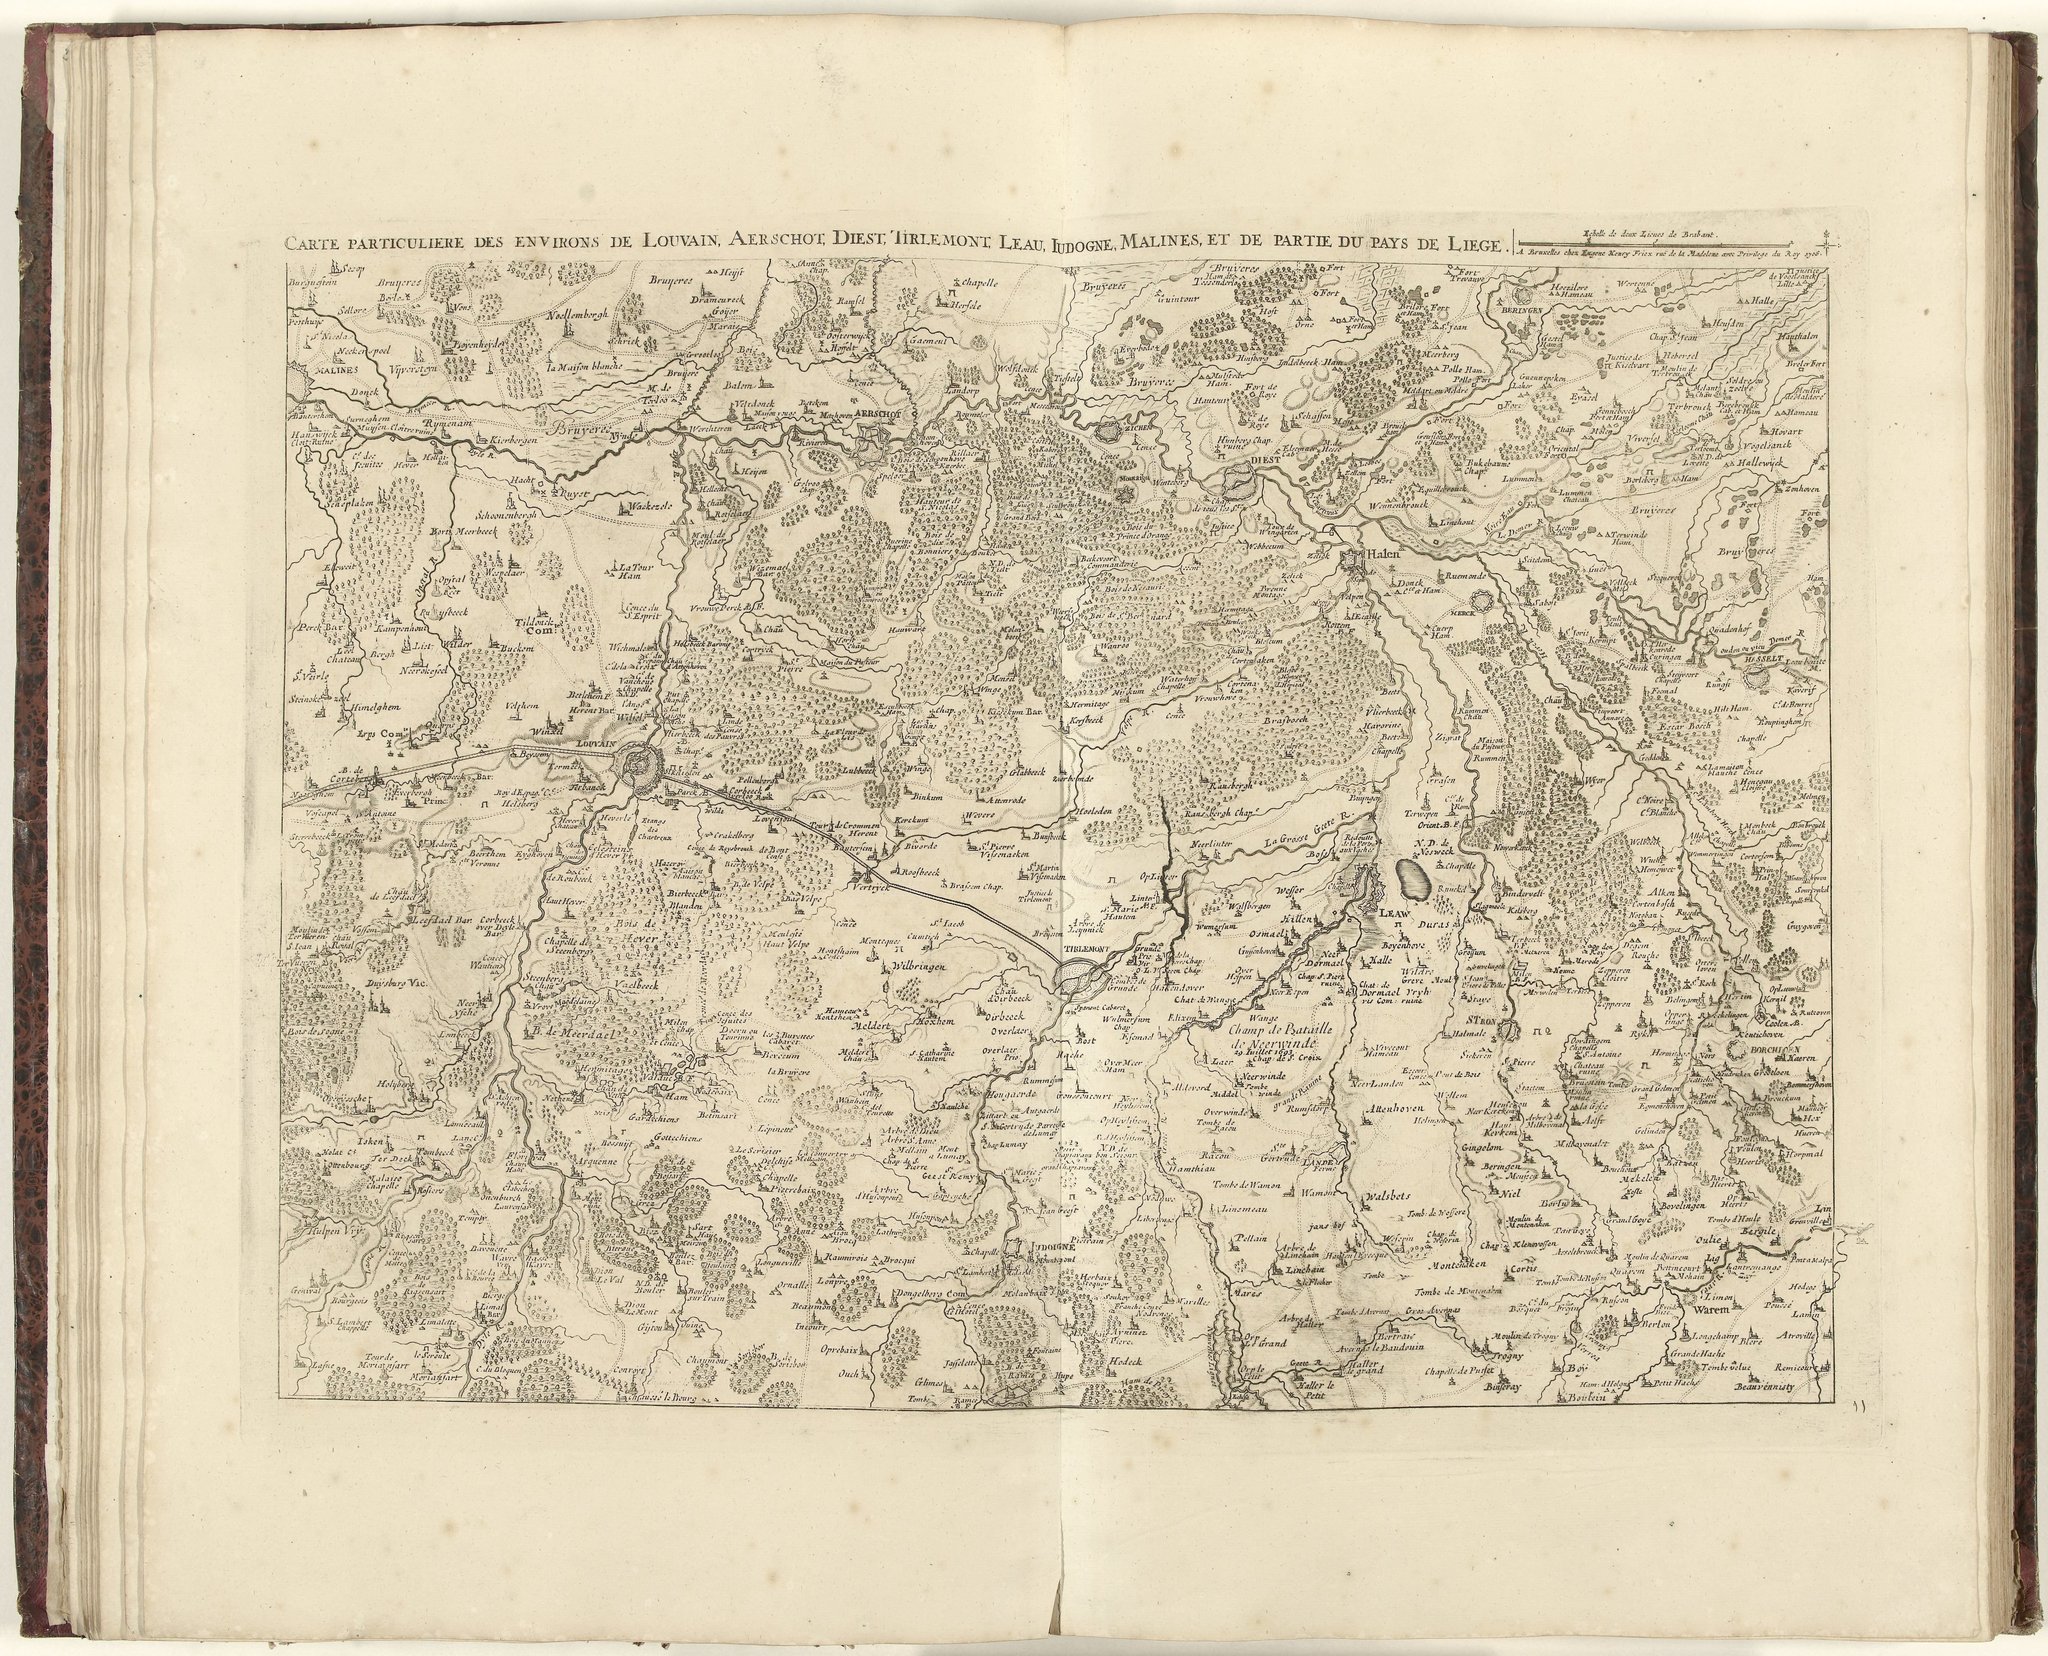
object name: print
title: Carte particuliere des environs de Louvain, Aerschot, Diest, Tirlemont, Leau, Judogne, Malines, et de partie du Pays de Liege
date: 1706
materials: paper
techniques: engraving, etching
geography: brussels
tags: marine charts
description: Kaart van een deel van Vlaams-Brabant met de steden Leuven, Aarschot, Diest, Tienen, Zoutleeuw, Jodoigne, Mechelen en een deel van het land van Luik, 1706. Onderdeel van een gebundelde verzameling van plannen van veldslagen en steden vermaard in de Spaanse Successieoorlog. Deze plaat behoort tot de eerste 24 platen die samen een zeer grote kaart van de Zuidelijke Nederlanden vormen.